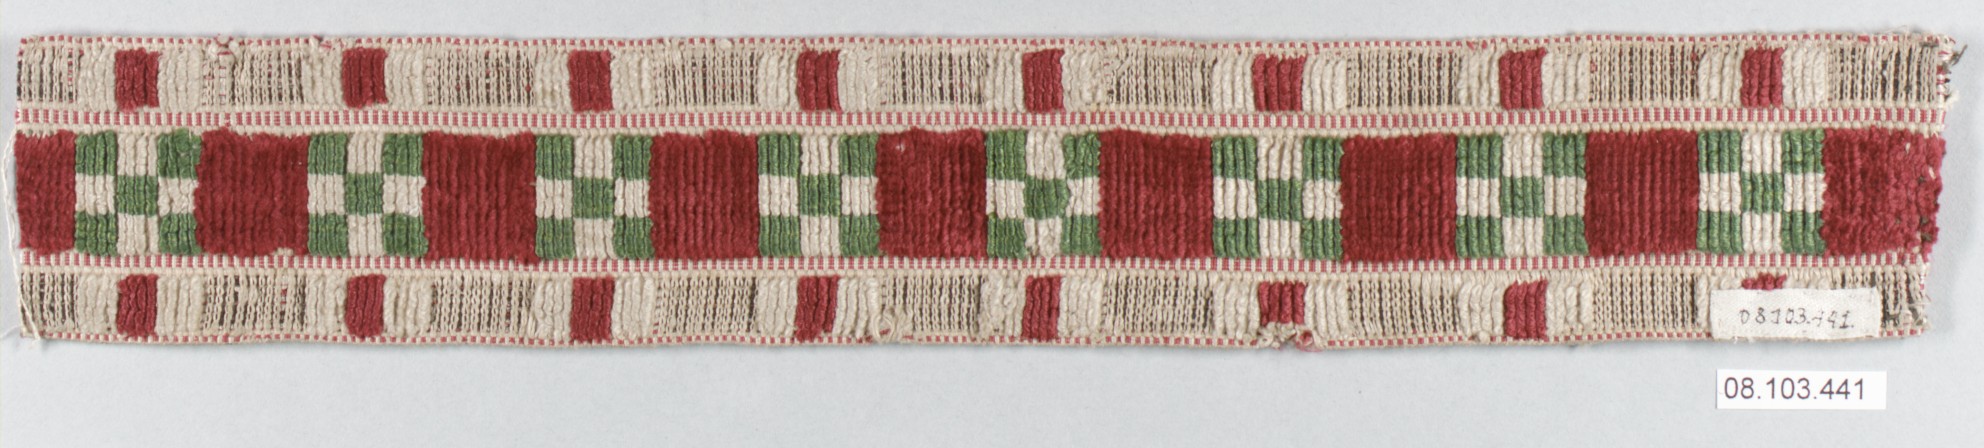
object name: galloon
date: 1701-1900